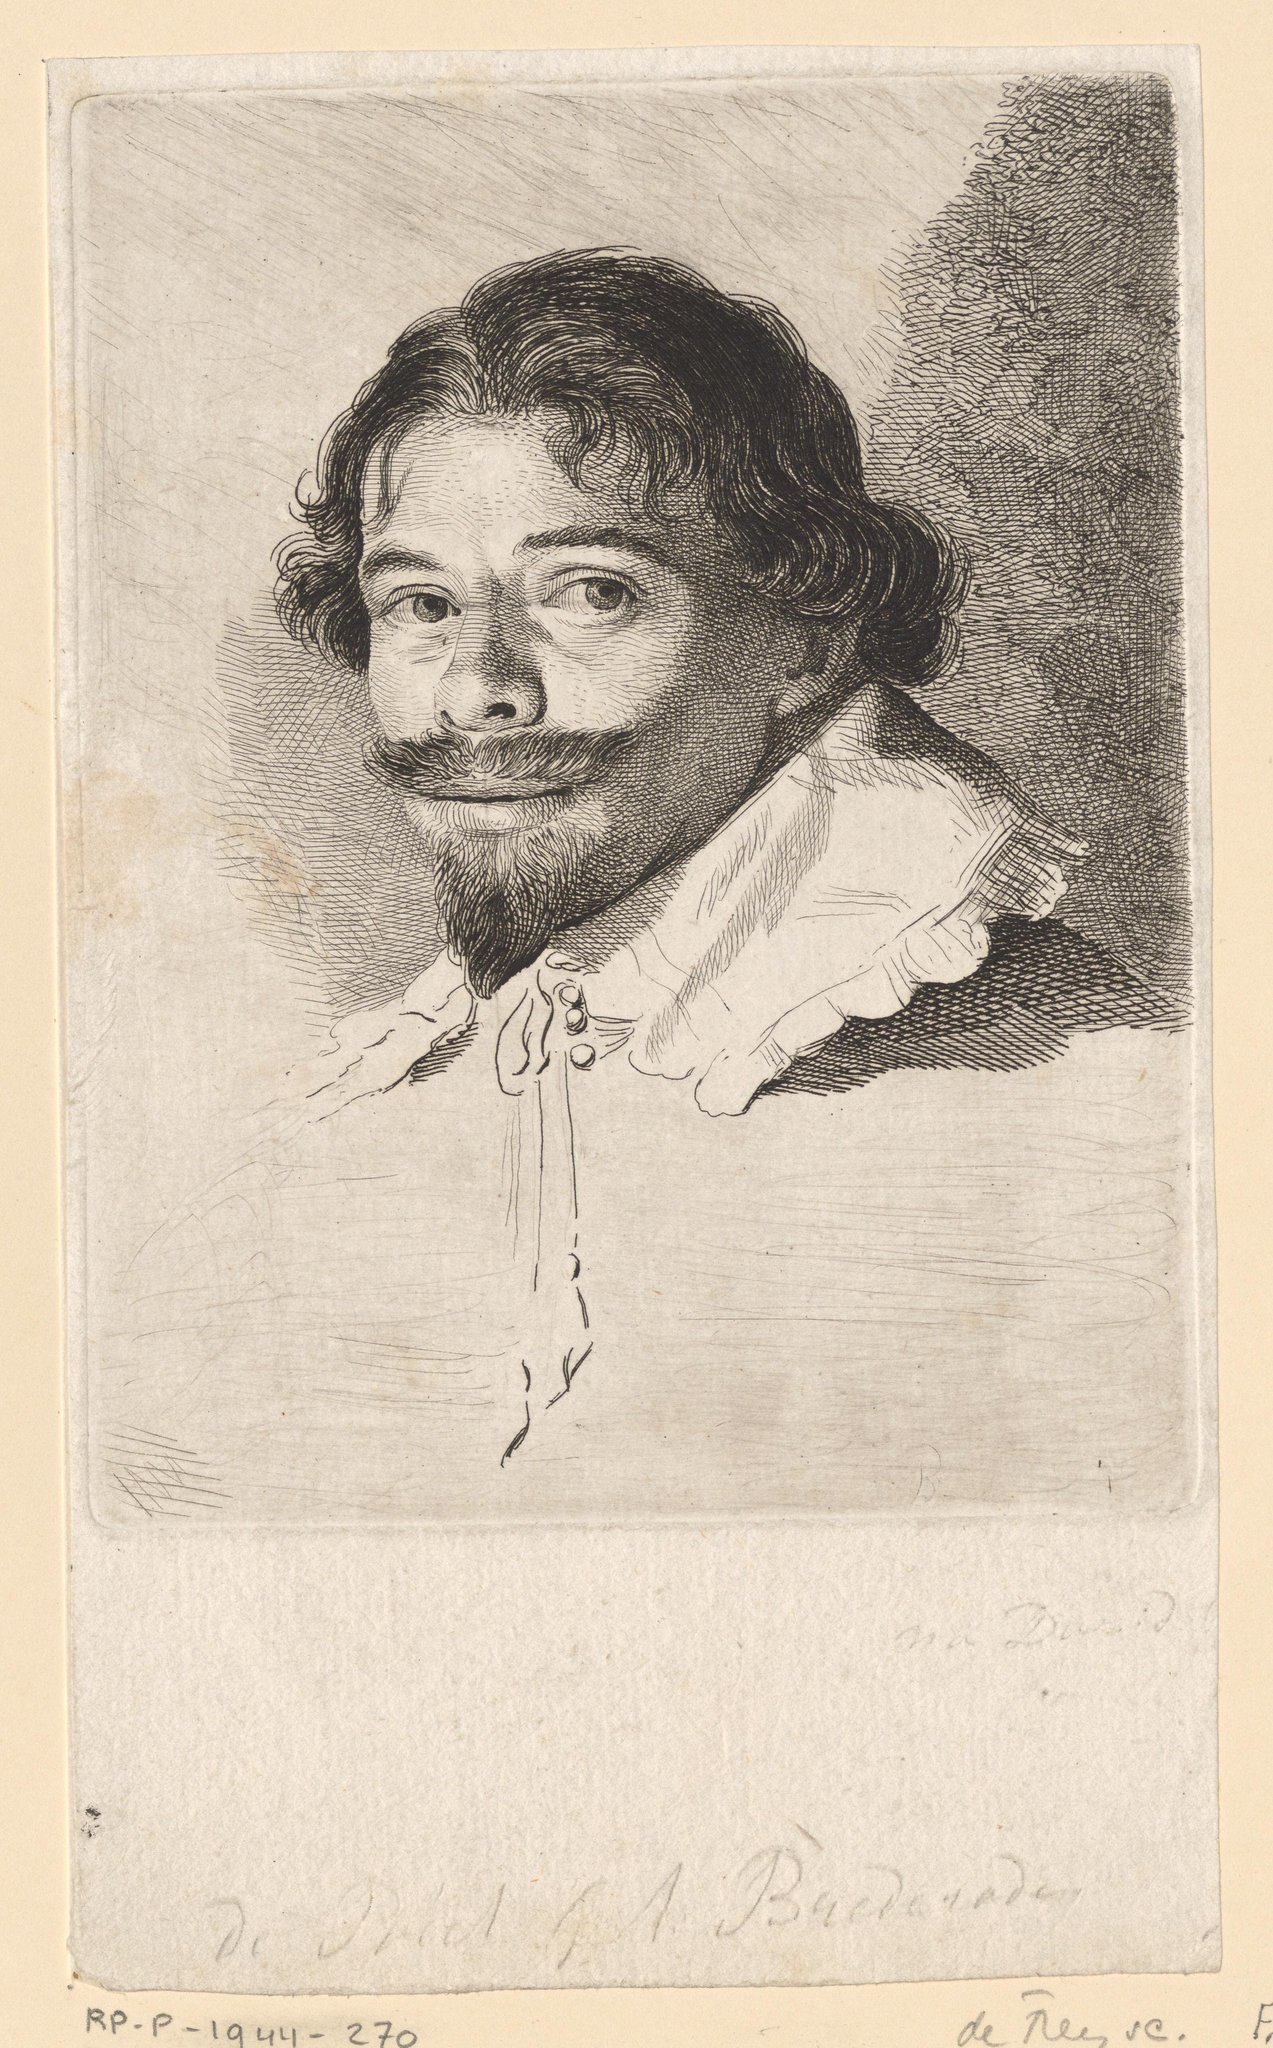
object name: print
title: Portret van David Bailly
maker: johannes pieter de frey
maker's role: draughtsman, print maker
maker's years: 1770-1834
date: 1801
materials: paper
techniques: etching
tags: leiden, david bailly, historical persons, portrait, self-portrait of artist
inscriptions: collector's mark: Lugt 2228